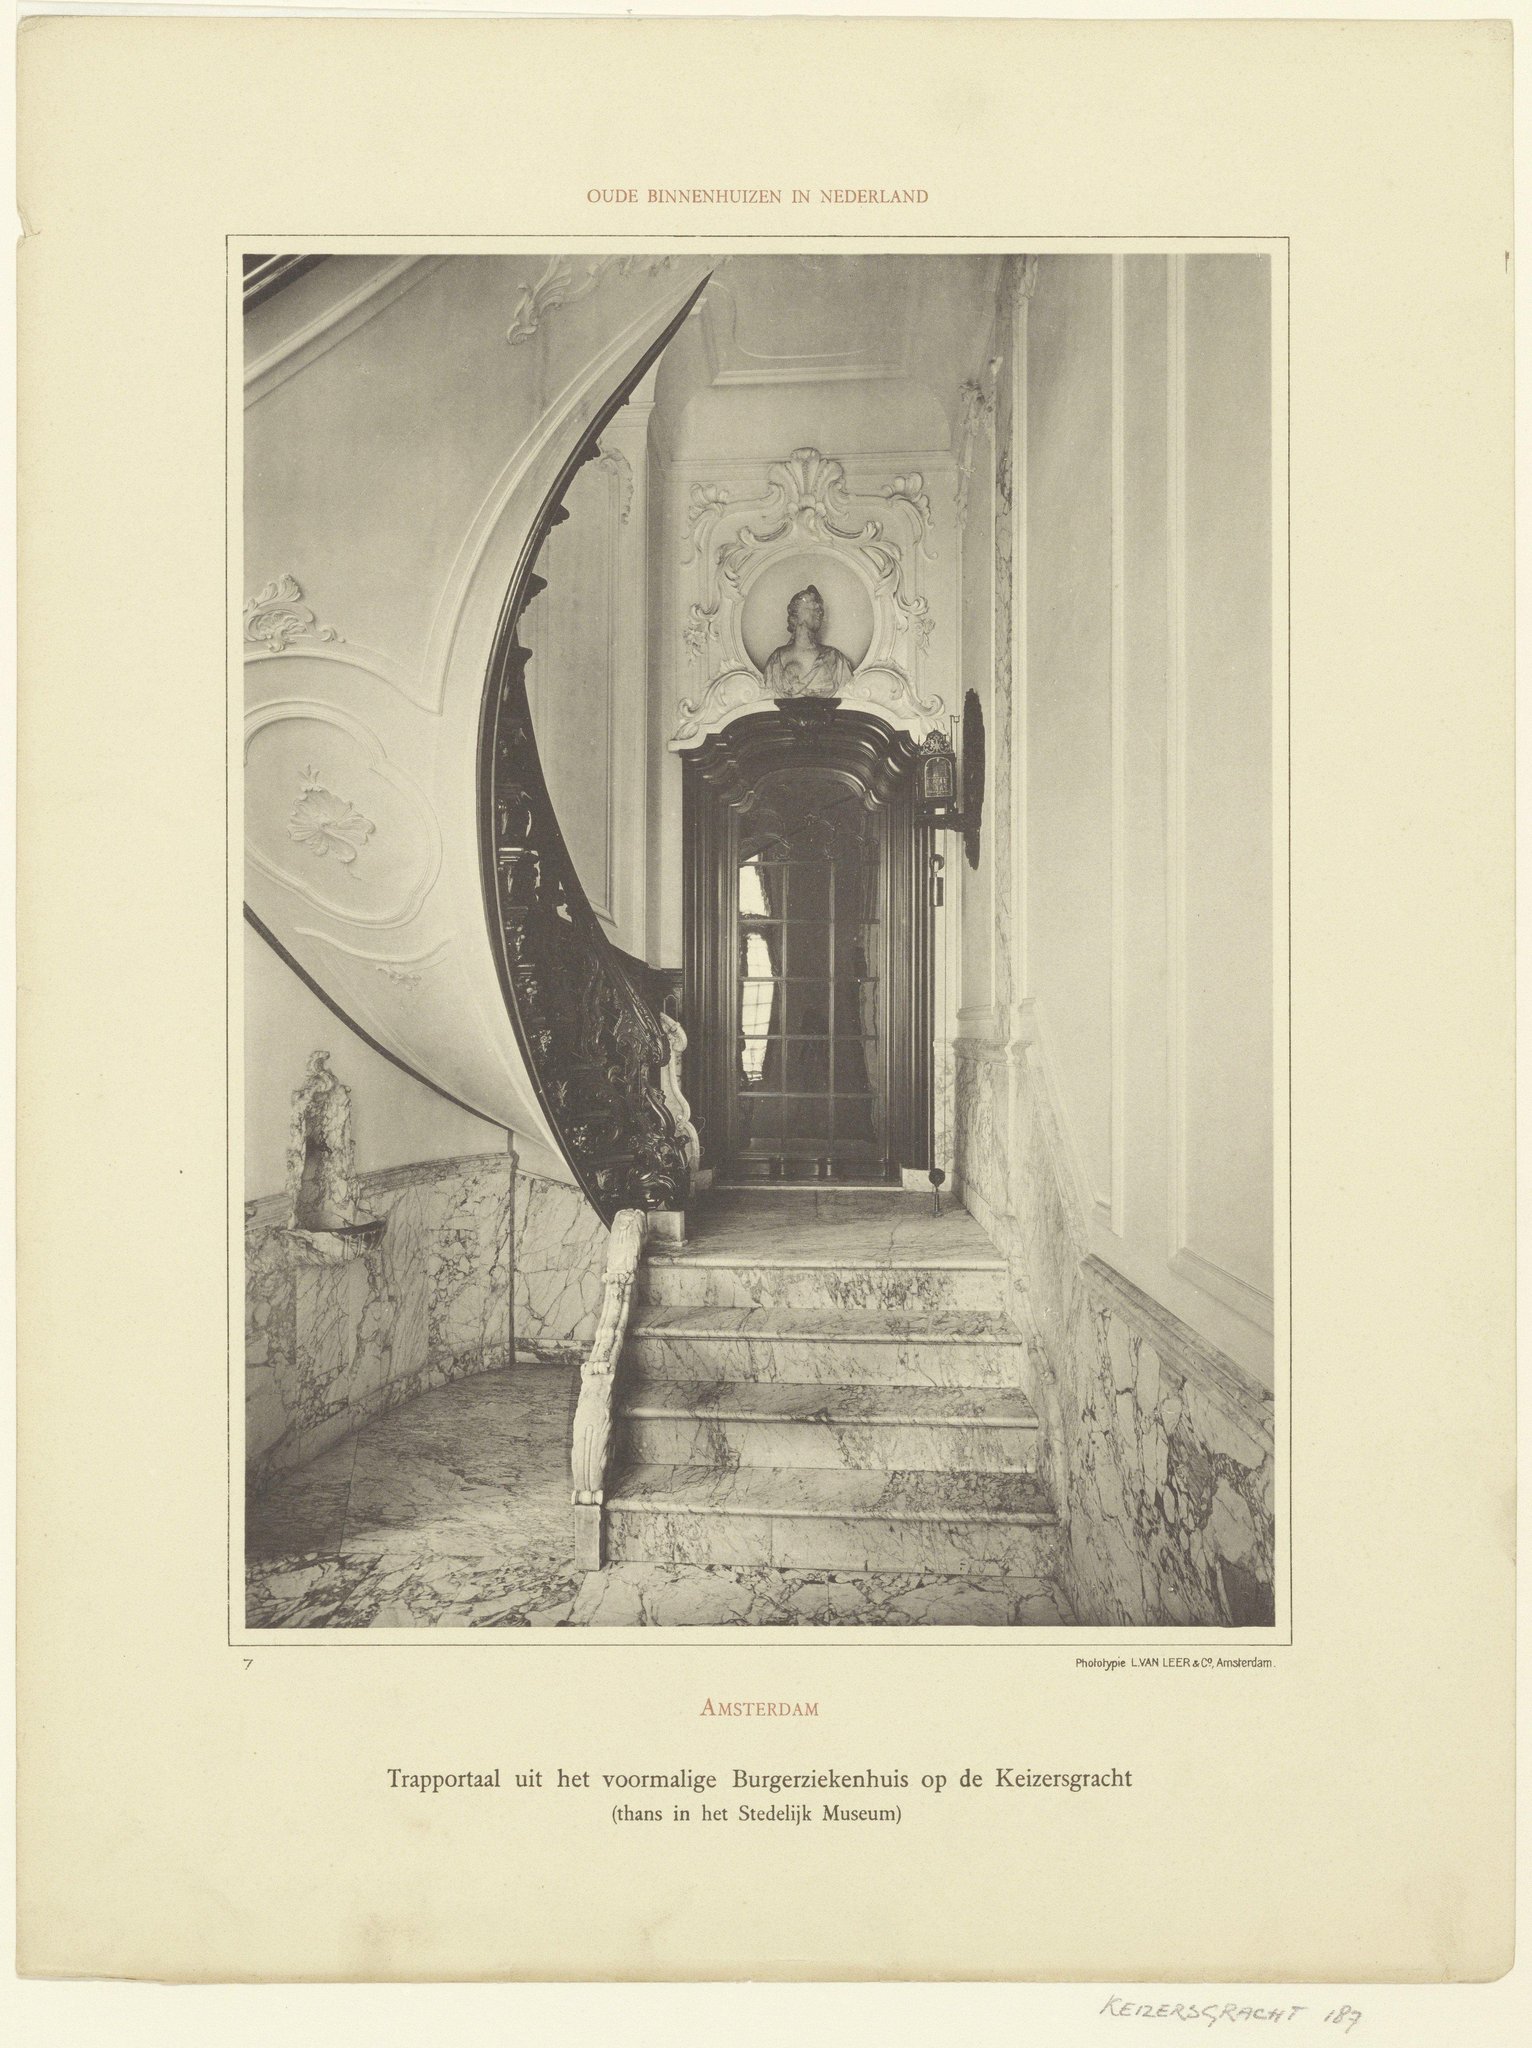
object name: architectural element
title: Onderdelen van het trapportaal uit het pand aan de Keizersgracht 187 te Amsterdam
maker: Anonymous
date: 1740-1760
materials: wood, marble